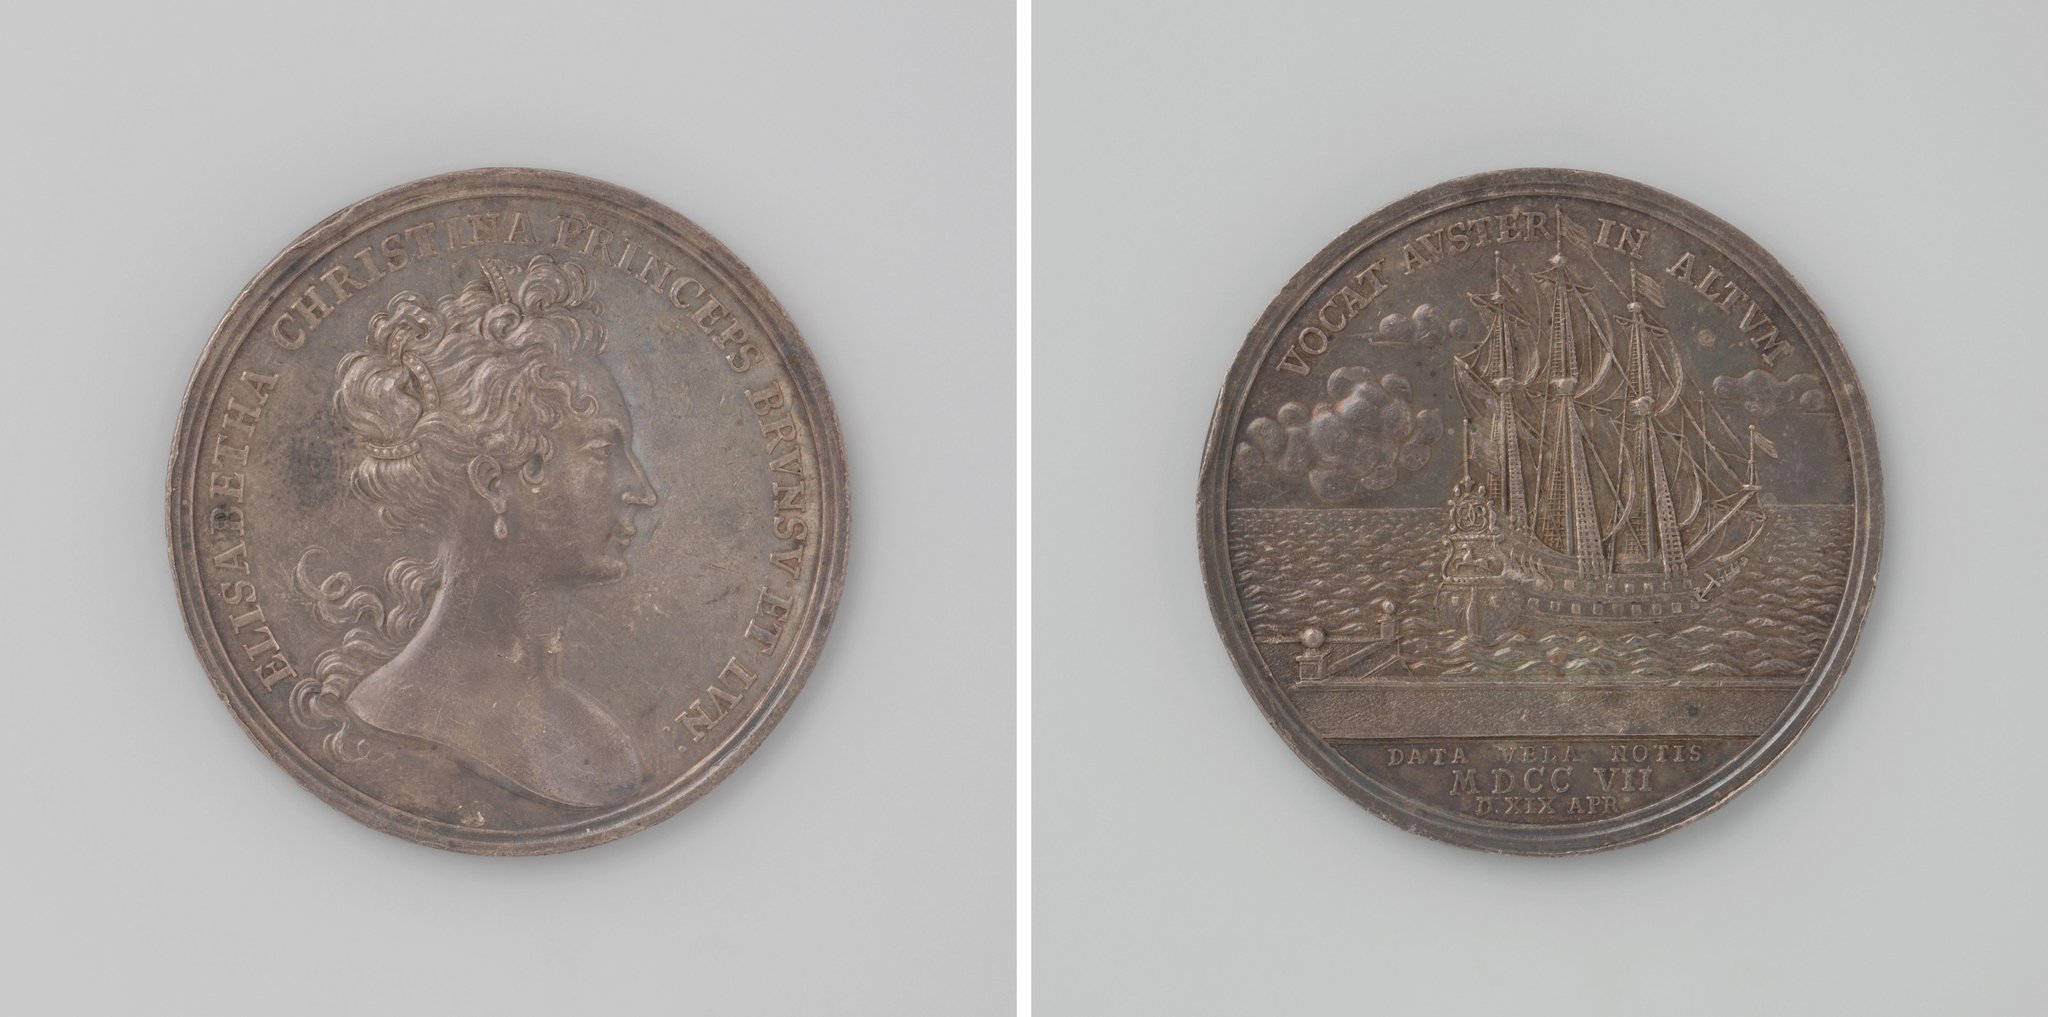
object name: history medal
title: Elisabeth Christine van Brunswijk-Wolfenbüttel vertrekt naar Spanje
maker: Anonymous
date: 1707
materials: silver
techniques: striking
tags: keizerin, elisabeth christina (keizerin van oostenrijk)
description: Zilveren penning. Voorzijde: borststuk vrouw binnen omschrift. Keerzijde: driemaster vertrekt onder gunstige wind binnen omschrift; afsnede: opschrift